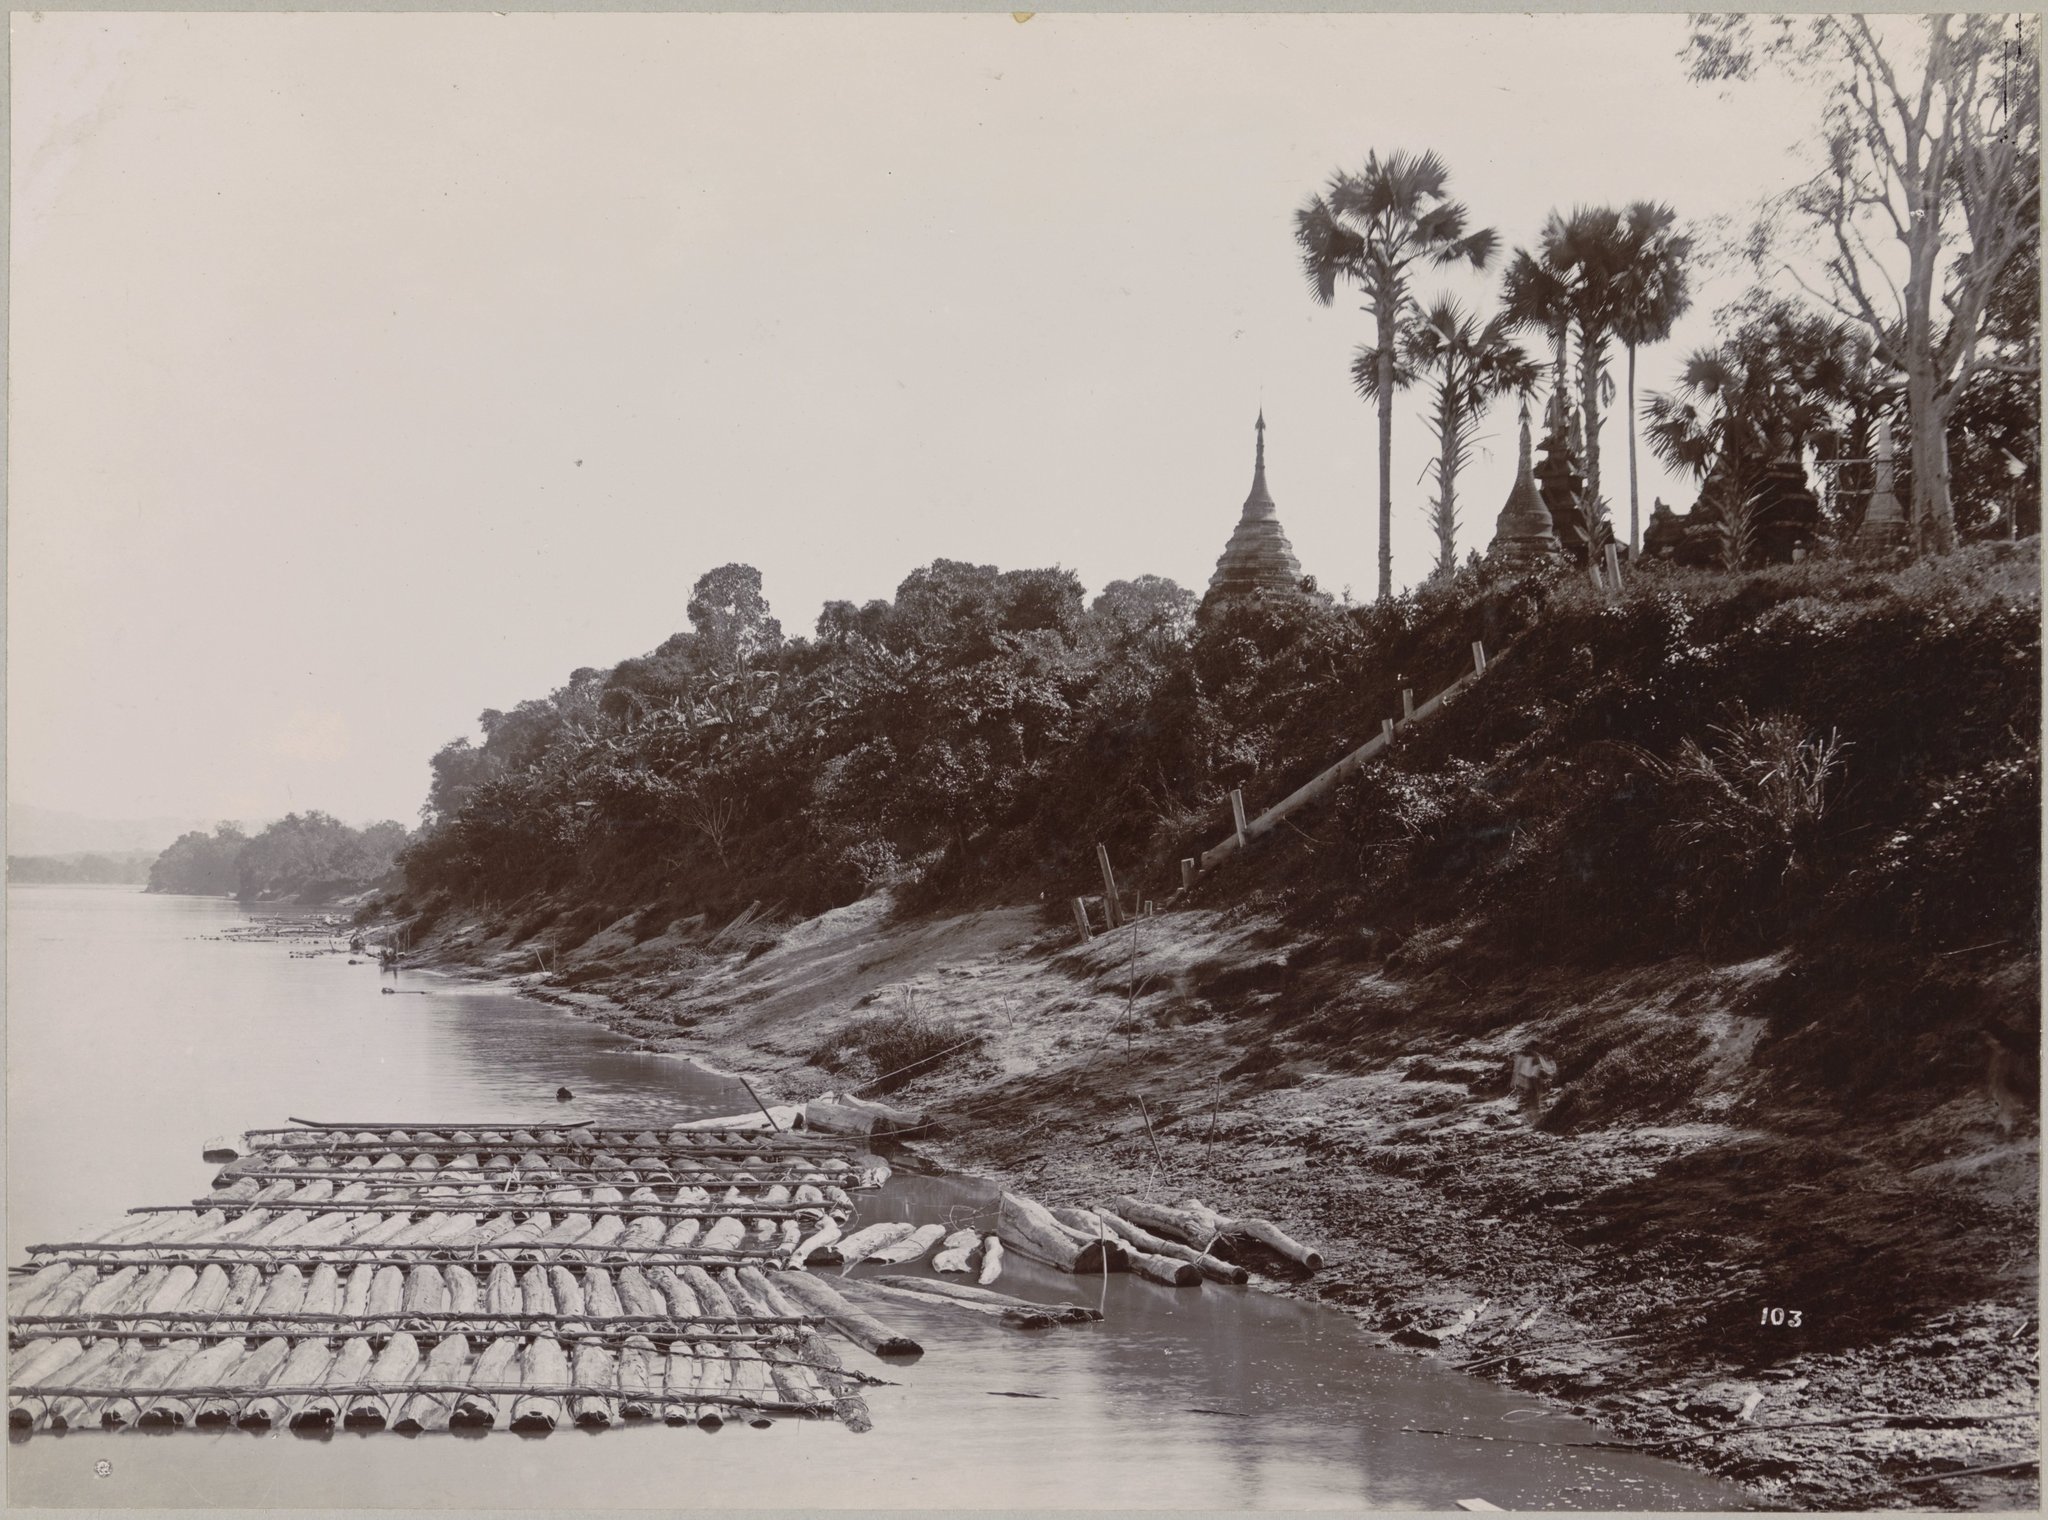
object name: photograph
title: Irrawady river, Bhamo, Myanmar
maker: Anonymous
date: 1895-1915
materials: cardboard, paper, photographic support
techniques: collodion silver print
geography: bhamo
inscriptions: number: ‘103’, inscription: ‘18. Irawaddy rivier bij Bhamo’